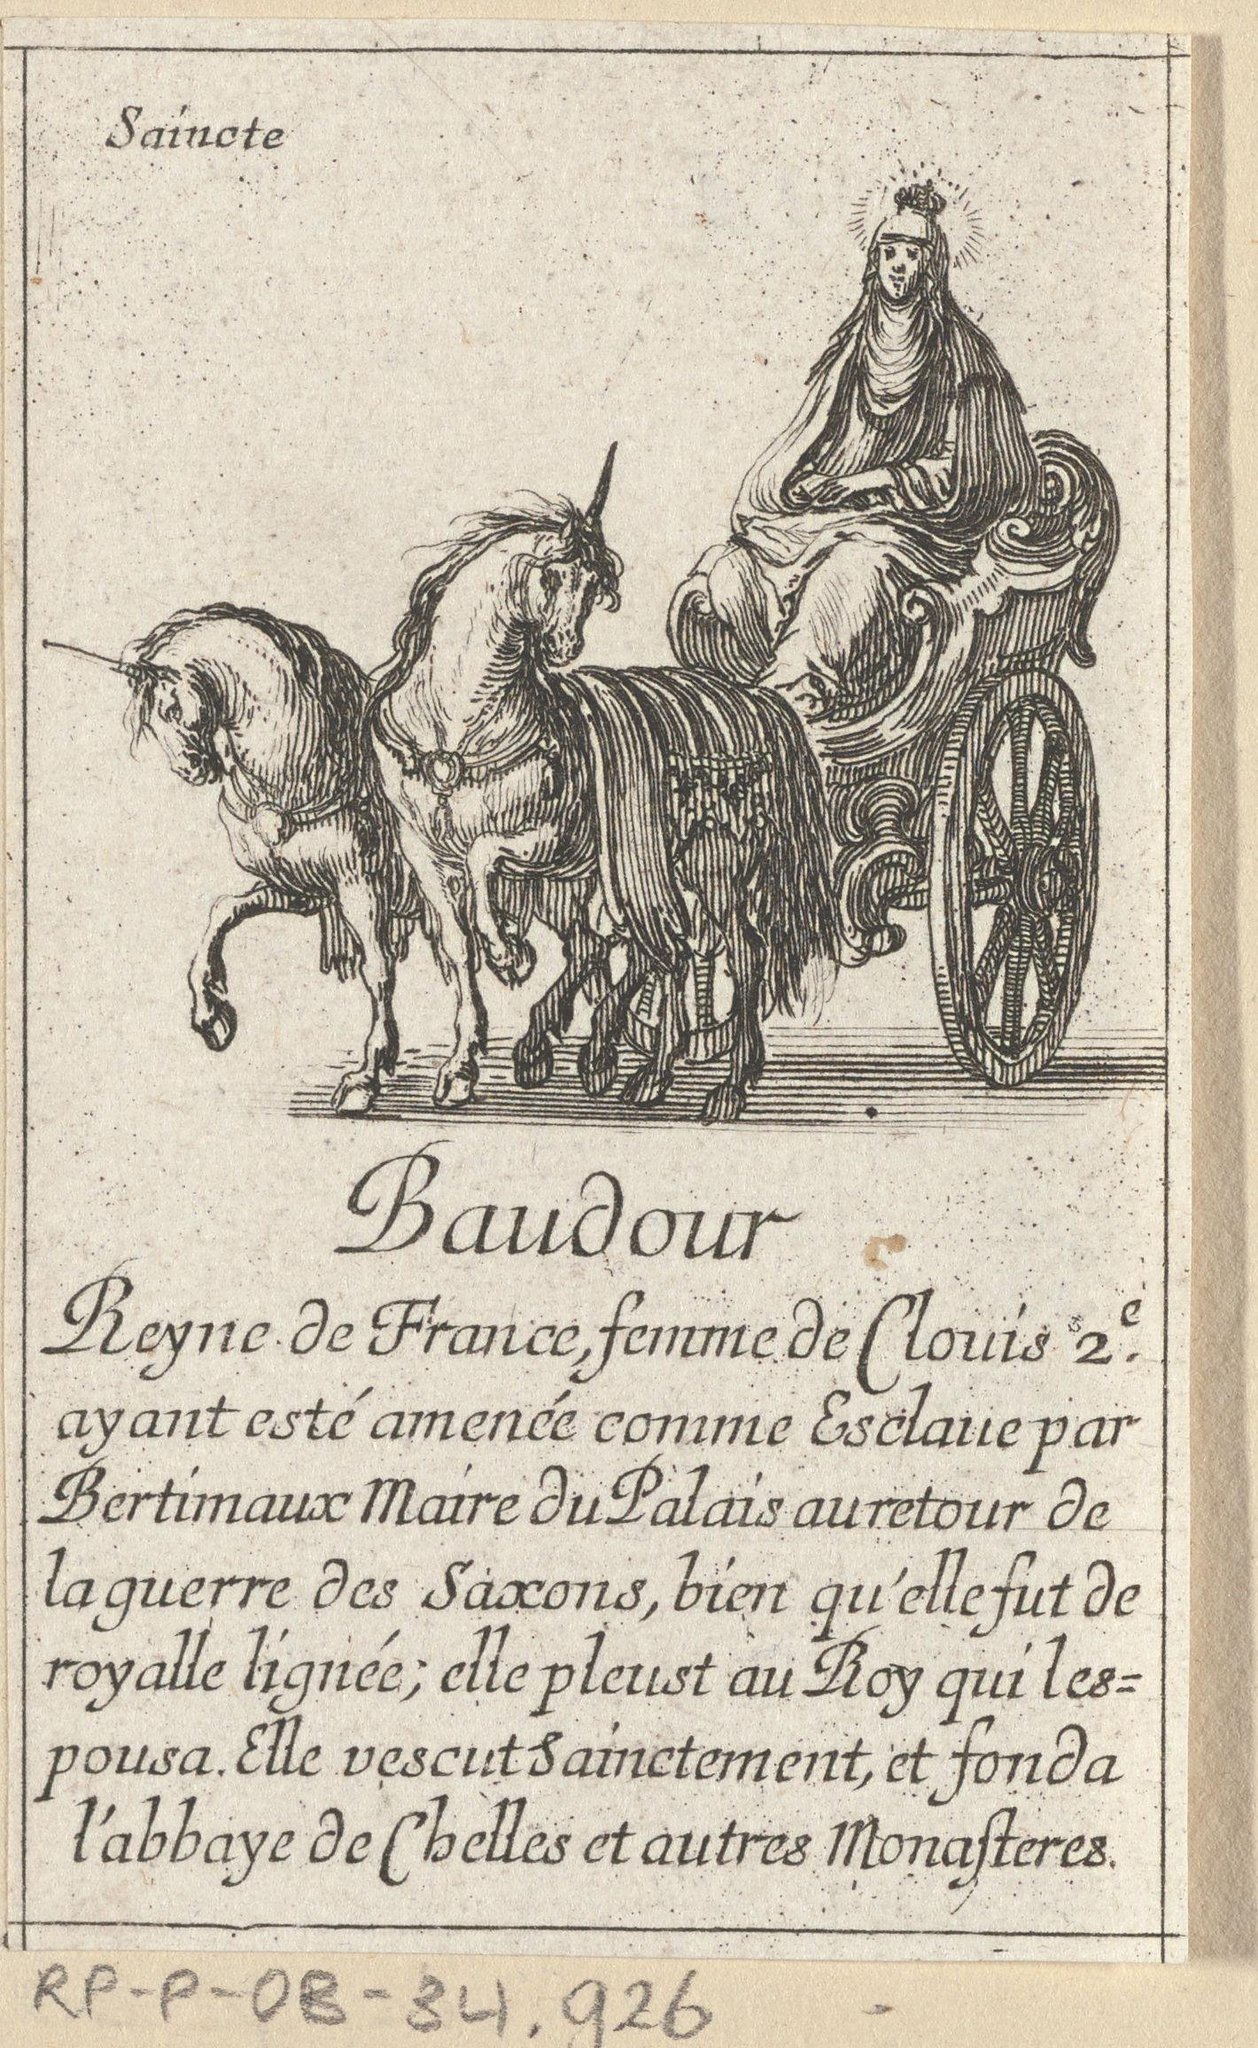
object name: playing card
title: Jeu des reynes renommées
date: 1620-1664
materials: paper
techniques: etching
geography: paris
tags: ruler, sovereign - bb - female ruler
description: Deze prent maakt deel uit van een kaartspel met 52 kaarten met voorstellingen van beroemde koninginnen. De serie is uitgedacht door Jean Desmarests de Saint-Sorlin in opdracht van Kardinaal Mazarin. Het kaartspel werd gemaakt voor de jonge Lodewijk XIV, samen met het Jeu des Fables, Jeu de la Géographie en Jeu des Rois de France.